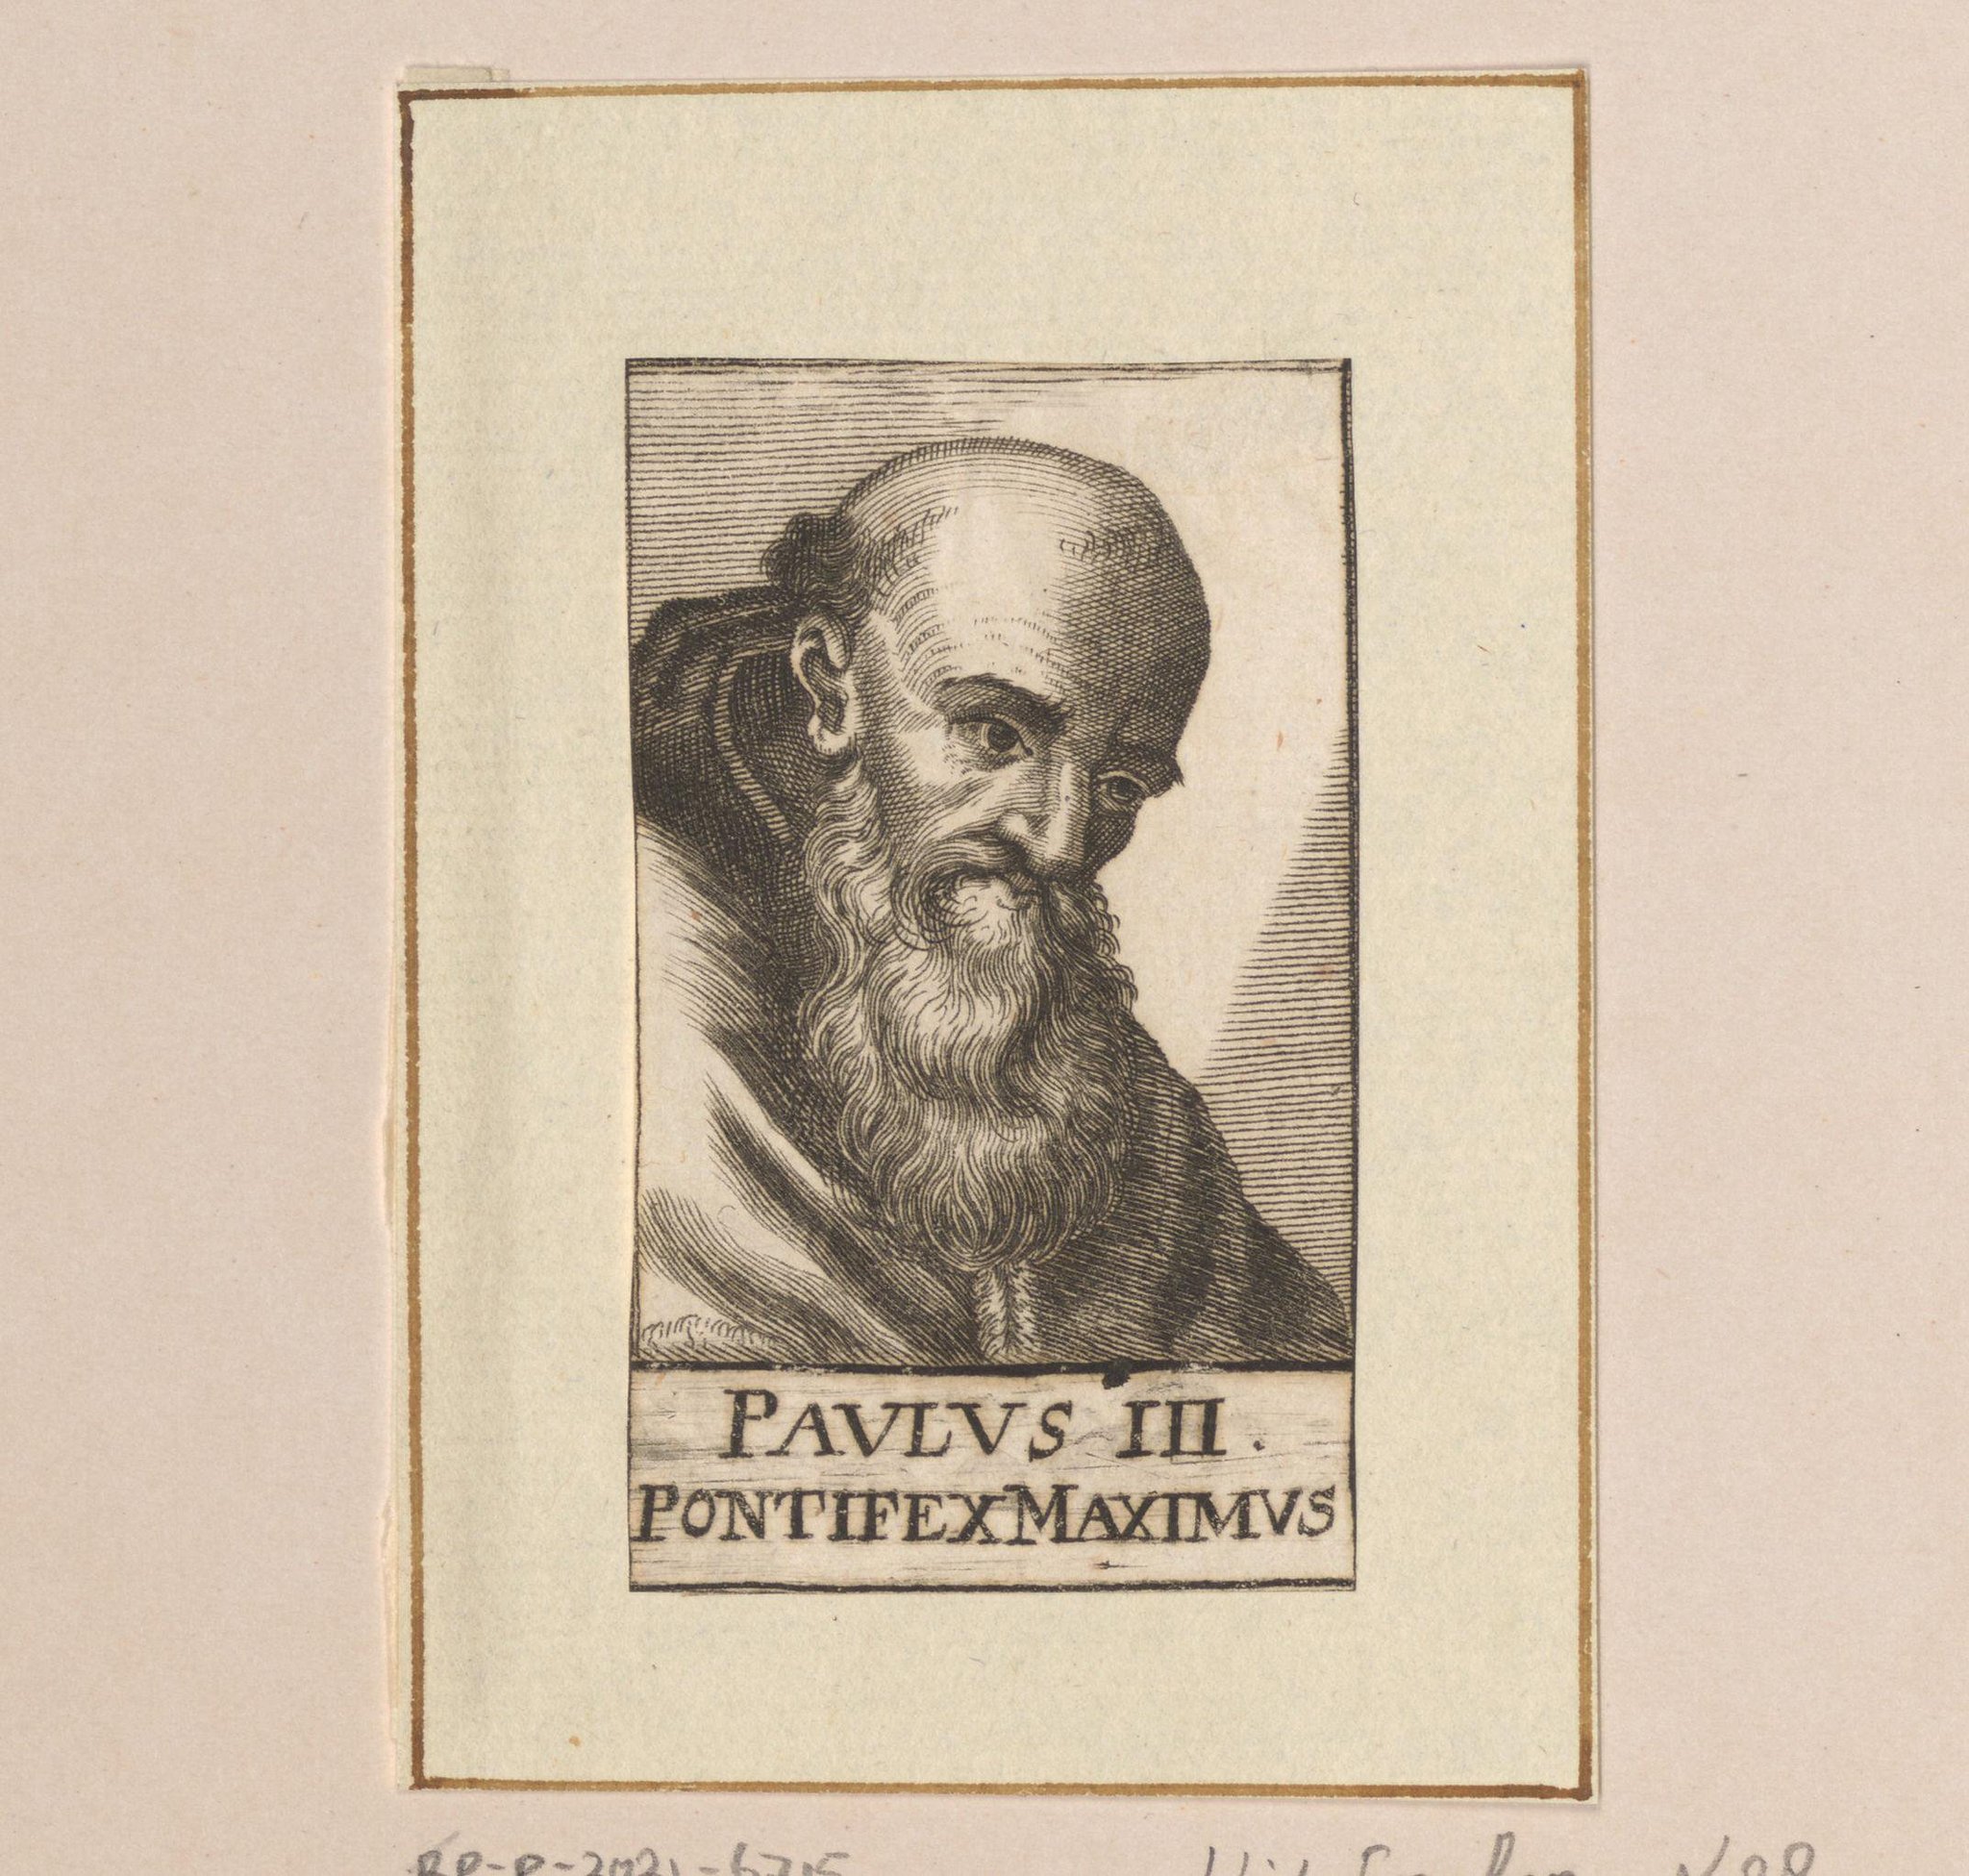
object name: book illustration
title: Portret van paus Paulus III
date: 1688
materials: paper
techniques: engraving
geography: nuremberg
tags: rome, priest, paulus iii, adult man, historical persons, pope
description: Prent maakt deel uit van een grotere prent die later is verknipt. Prent uit: Freher, Paul. Theatrum virorum eruditione clarorum. Neurenberg: Johann Hoffmann, 1688.